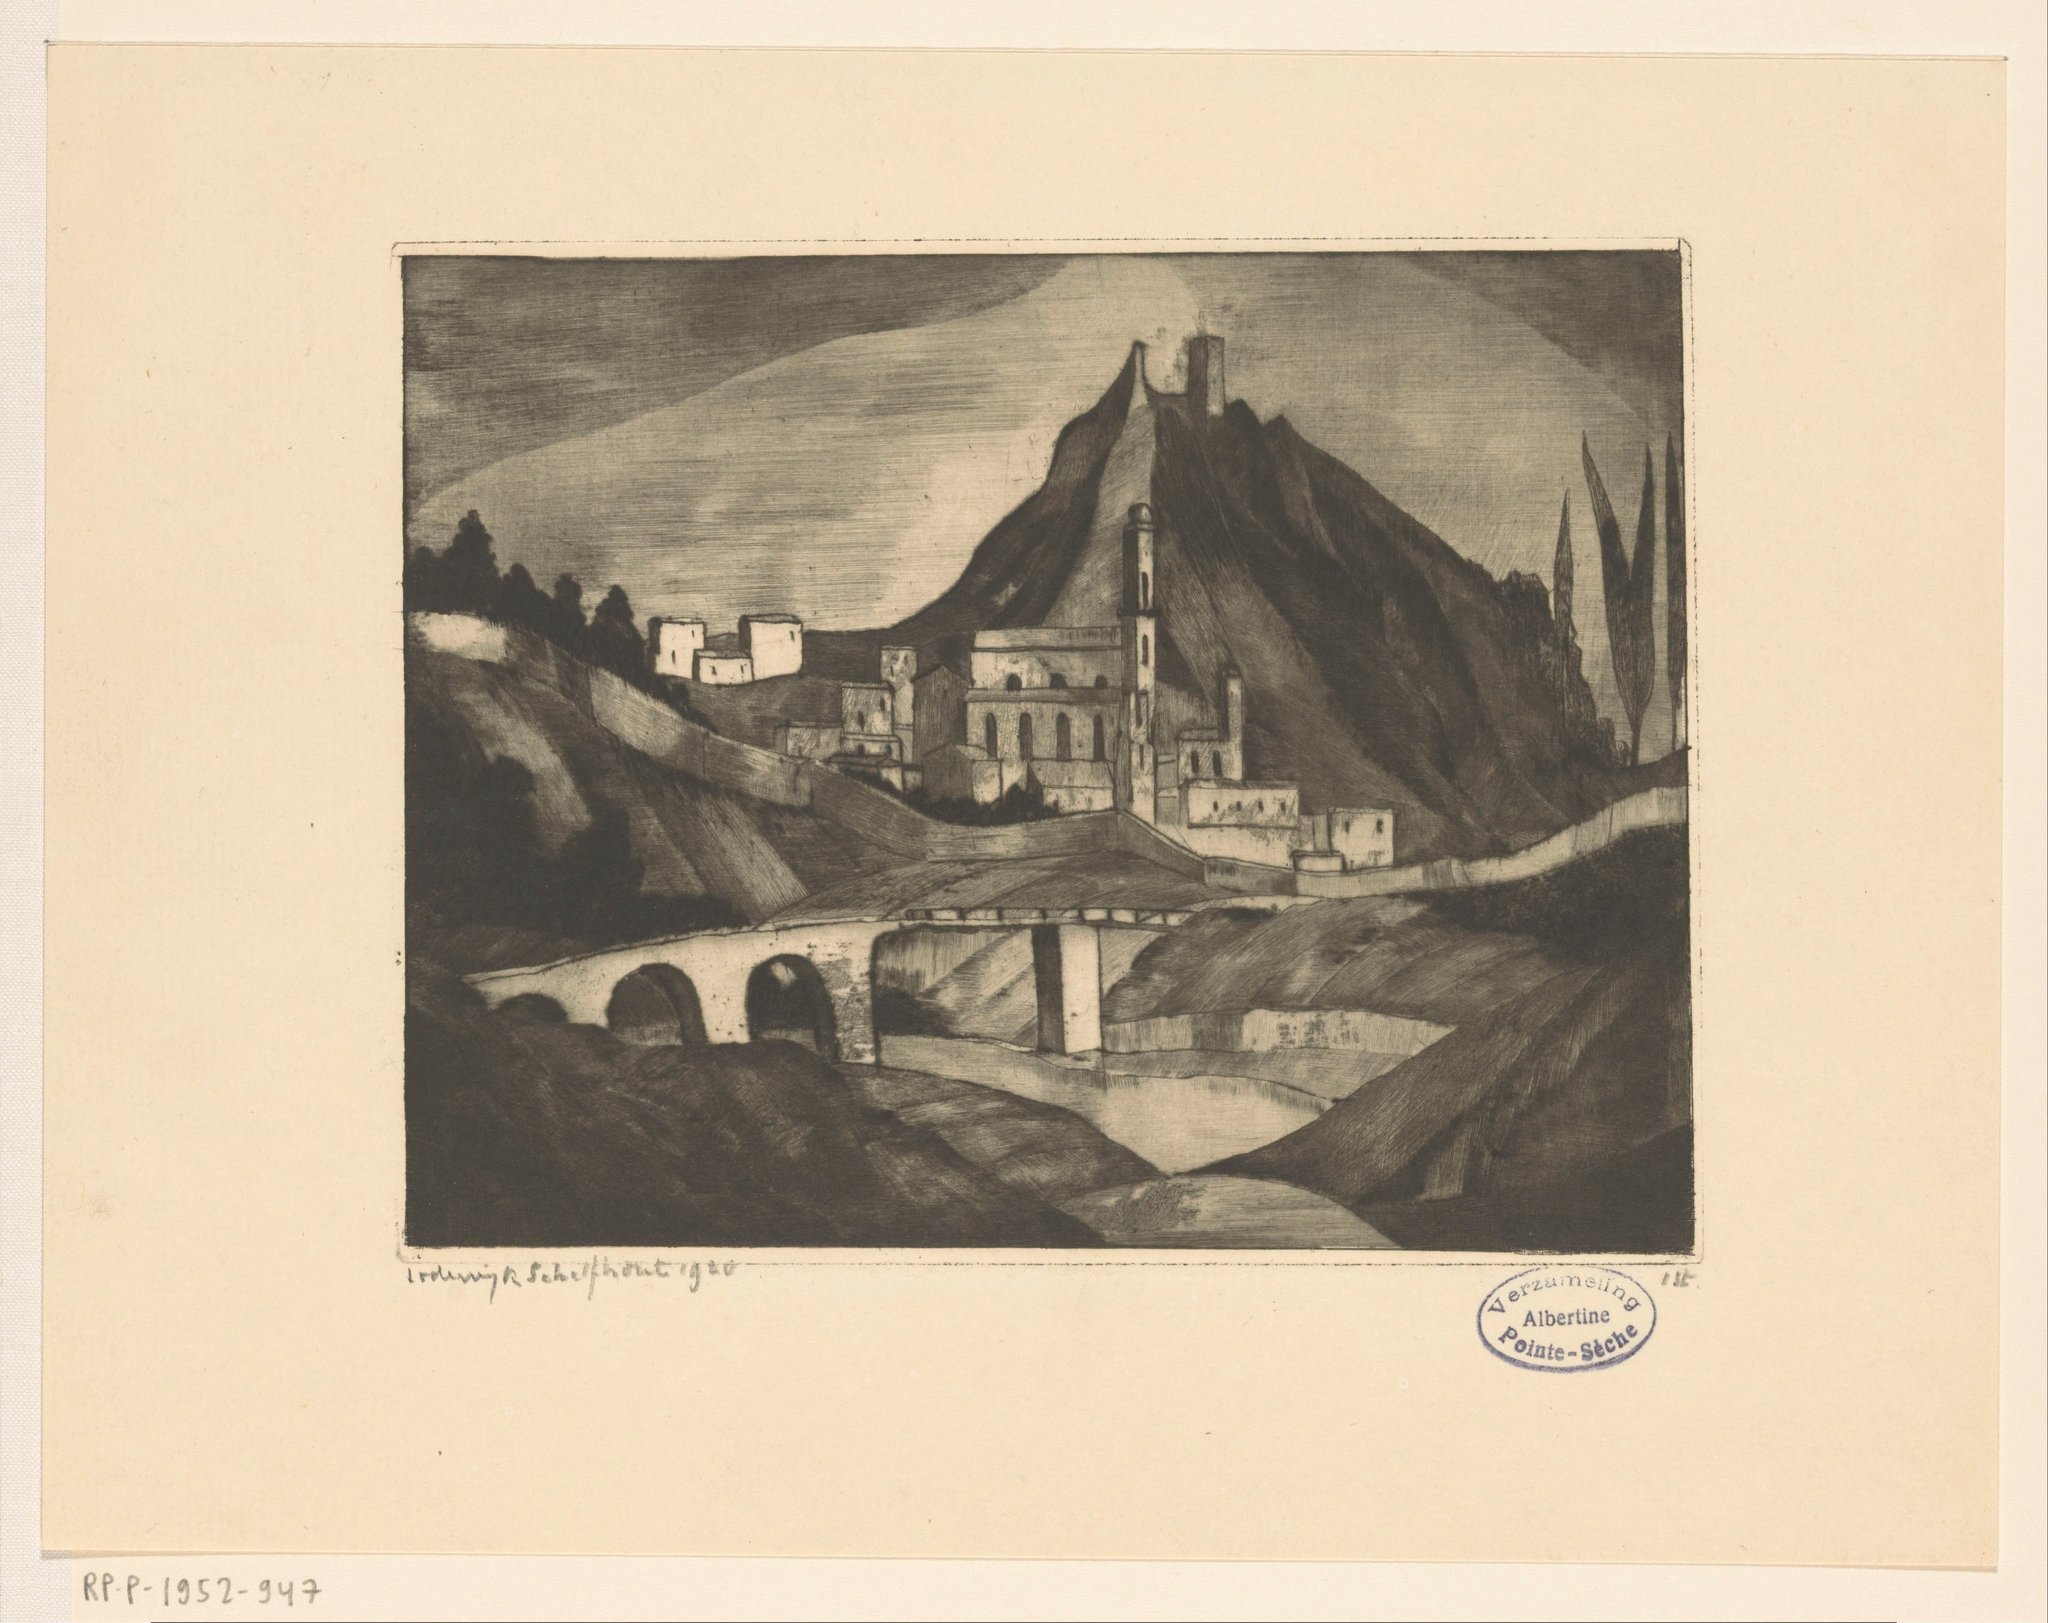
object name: print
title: Corte I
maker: lodewijk schelfhout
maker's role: draughtsman, print maker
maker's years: 1881-1943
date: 1920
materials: paper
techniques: drypoint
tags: city-view, and landscape with man-made constructions, bridge, mountains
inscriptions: collector's mark: Lugt 5i, collector's mark: Lugt 2228, collector's mark: Lugt 2760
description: De plaats Corte, gelegen in het midden van Corsica. Op de voorgrond een brug over een rivier. Op de achtergrond, op de top van een berg, de burcht van Corte.